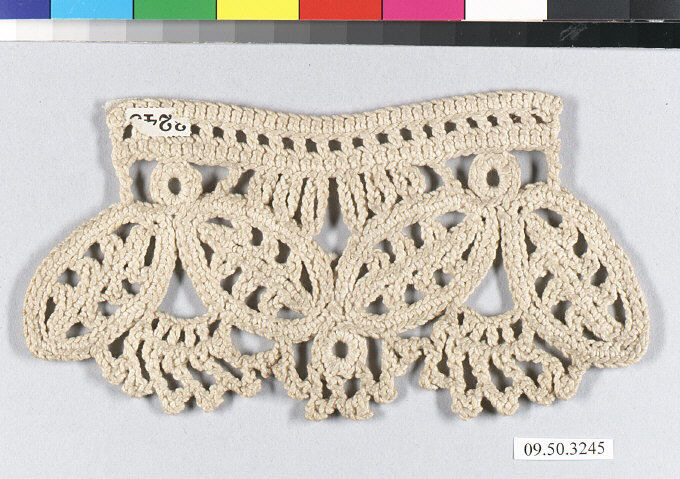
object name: sample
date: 1801-1900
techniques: crochet